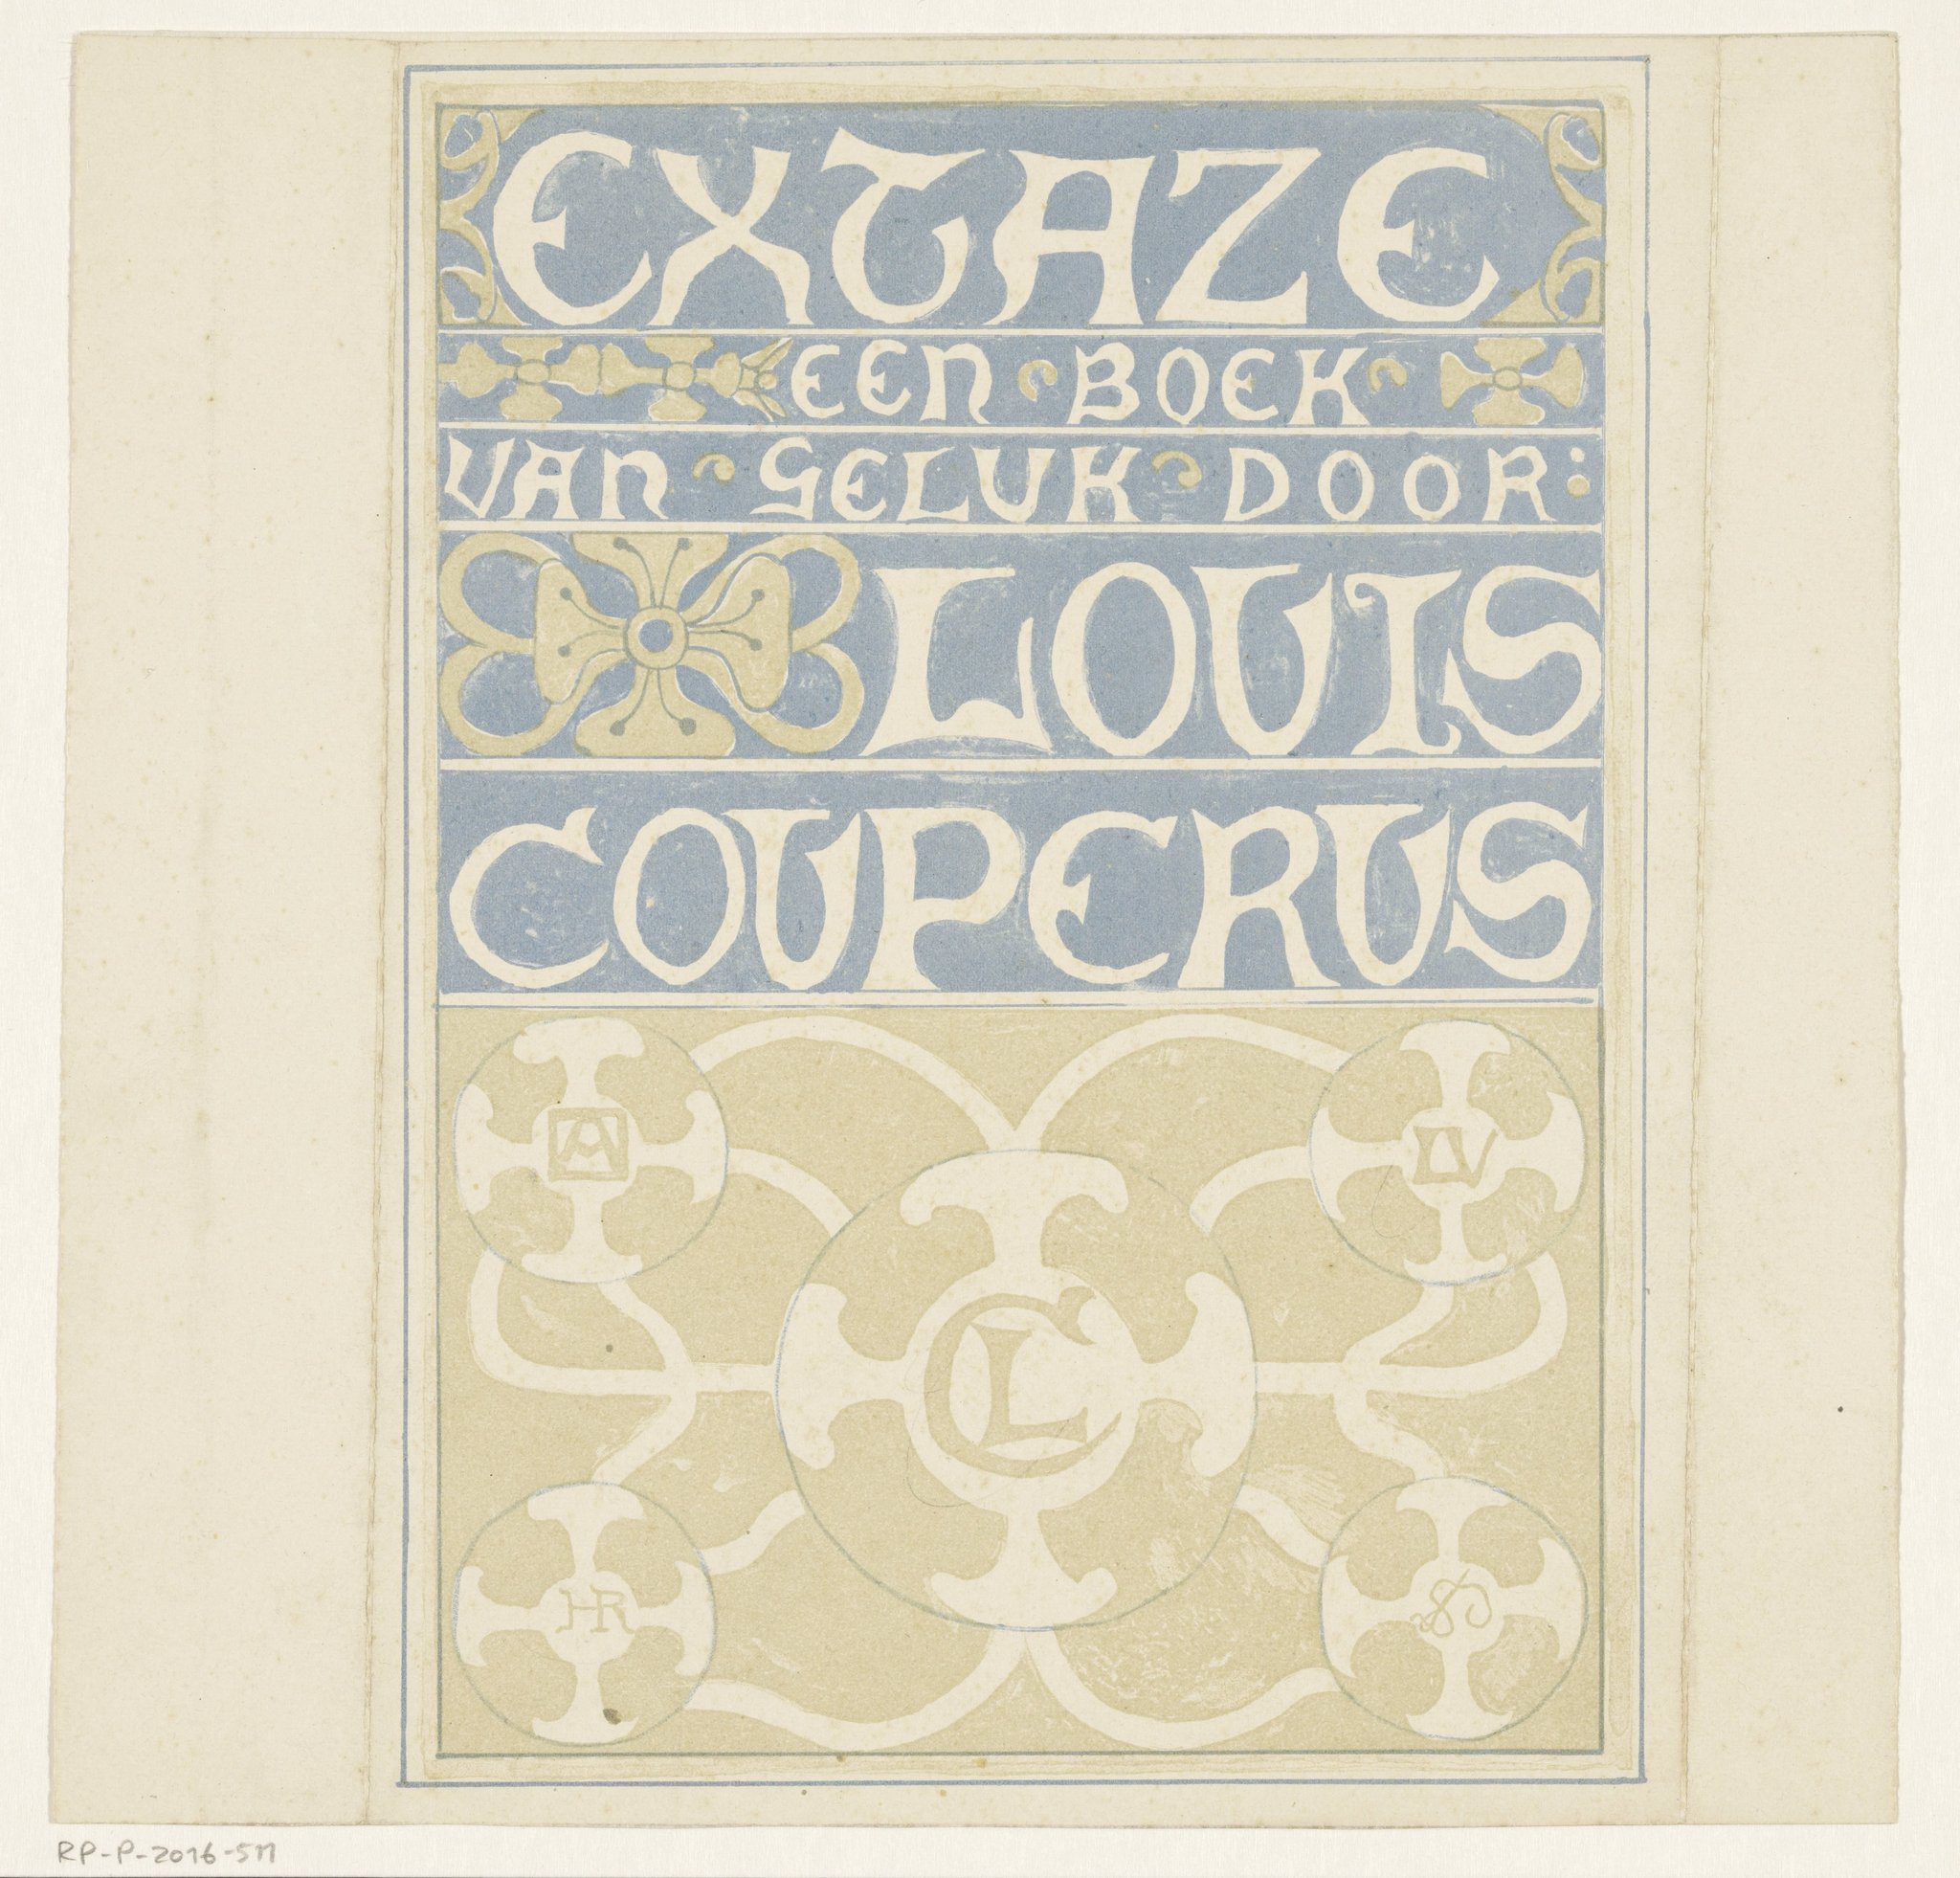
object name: study for binding design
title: Bandontwerp voor: Louis Couperus, Extaze: een boek van geluk, 1894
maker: richard nicolaüs roland holst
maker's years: 1868-1938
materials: paper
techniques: lithograph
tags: ornament ~ circle and derived from circle, e.g.: guilloche, flowers ~ ornament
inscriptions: collector's mark: Lugt 2228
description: Decoratieve belettering versierd met bloemmotieven. Onderaan vier cirkels met daarin onder andere de monogrammen van Louis Couperus en Richard Roland Holst.